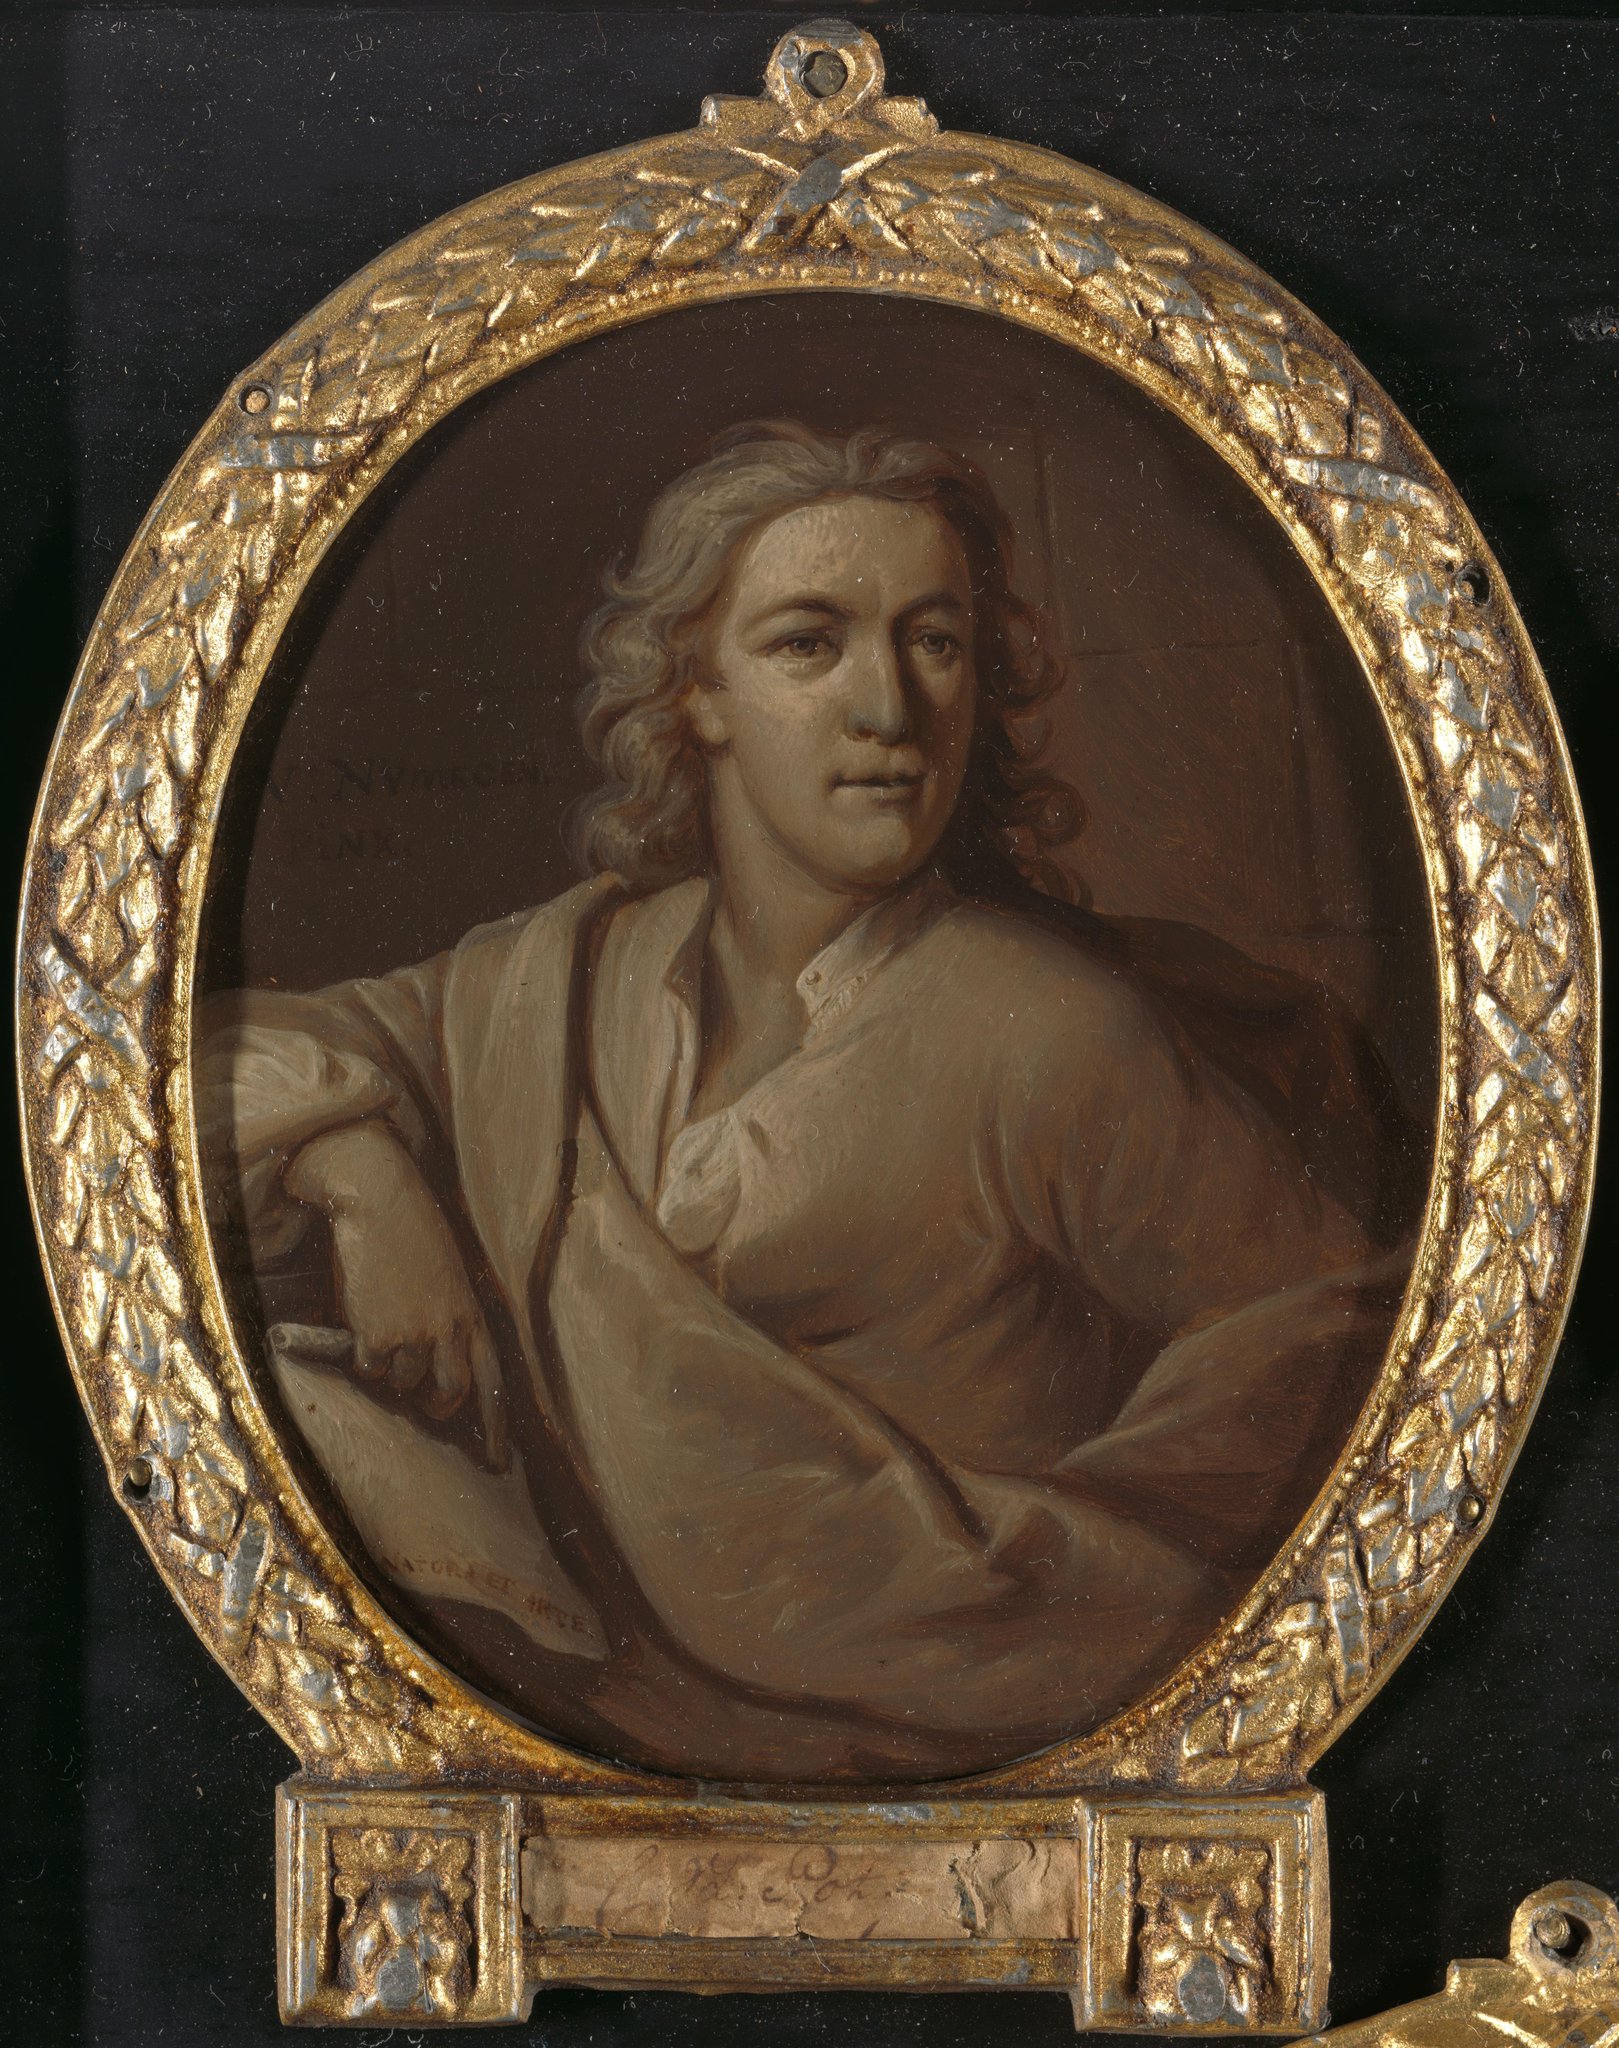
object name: painting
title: Portrait of Cornelis van der Pot (1736-1805), Merchant and Poet in Rotterdam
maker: dionys van nijmegen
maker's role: draughtsman, painter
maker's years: 1705-1798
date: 1732-1771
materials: copper, oil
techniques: grisaille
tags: portrait of a writer, writer, poet, author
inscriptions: signature: ‘D: V: Nymegen. Pinx.’, inscription: ‘Corn. Van der Pot. 1707’, inscription: ‘Natura et Arte’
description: Portret van Cornelis van der Pot (1707-1728). Koopman en dichter te Rotterdam. Buste in ovaal, het hoofd naar rechts gekeerd, een papier in de rechterhand. Onderdeel van een verzameling portretten van Nederlandse dichters.